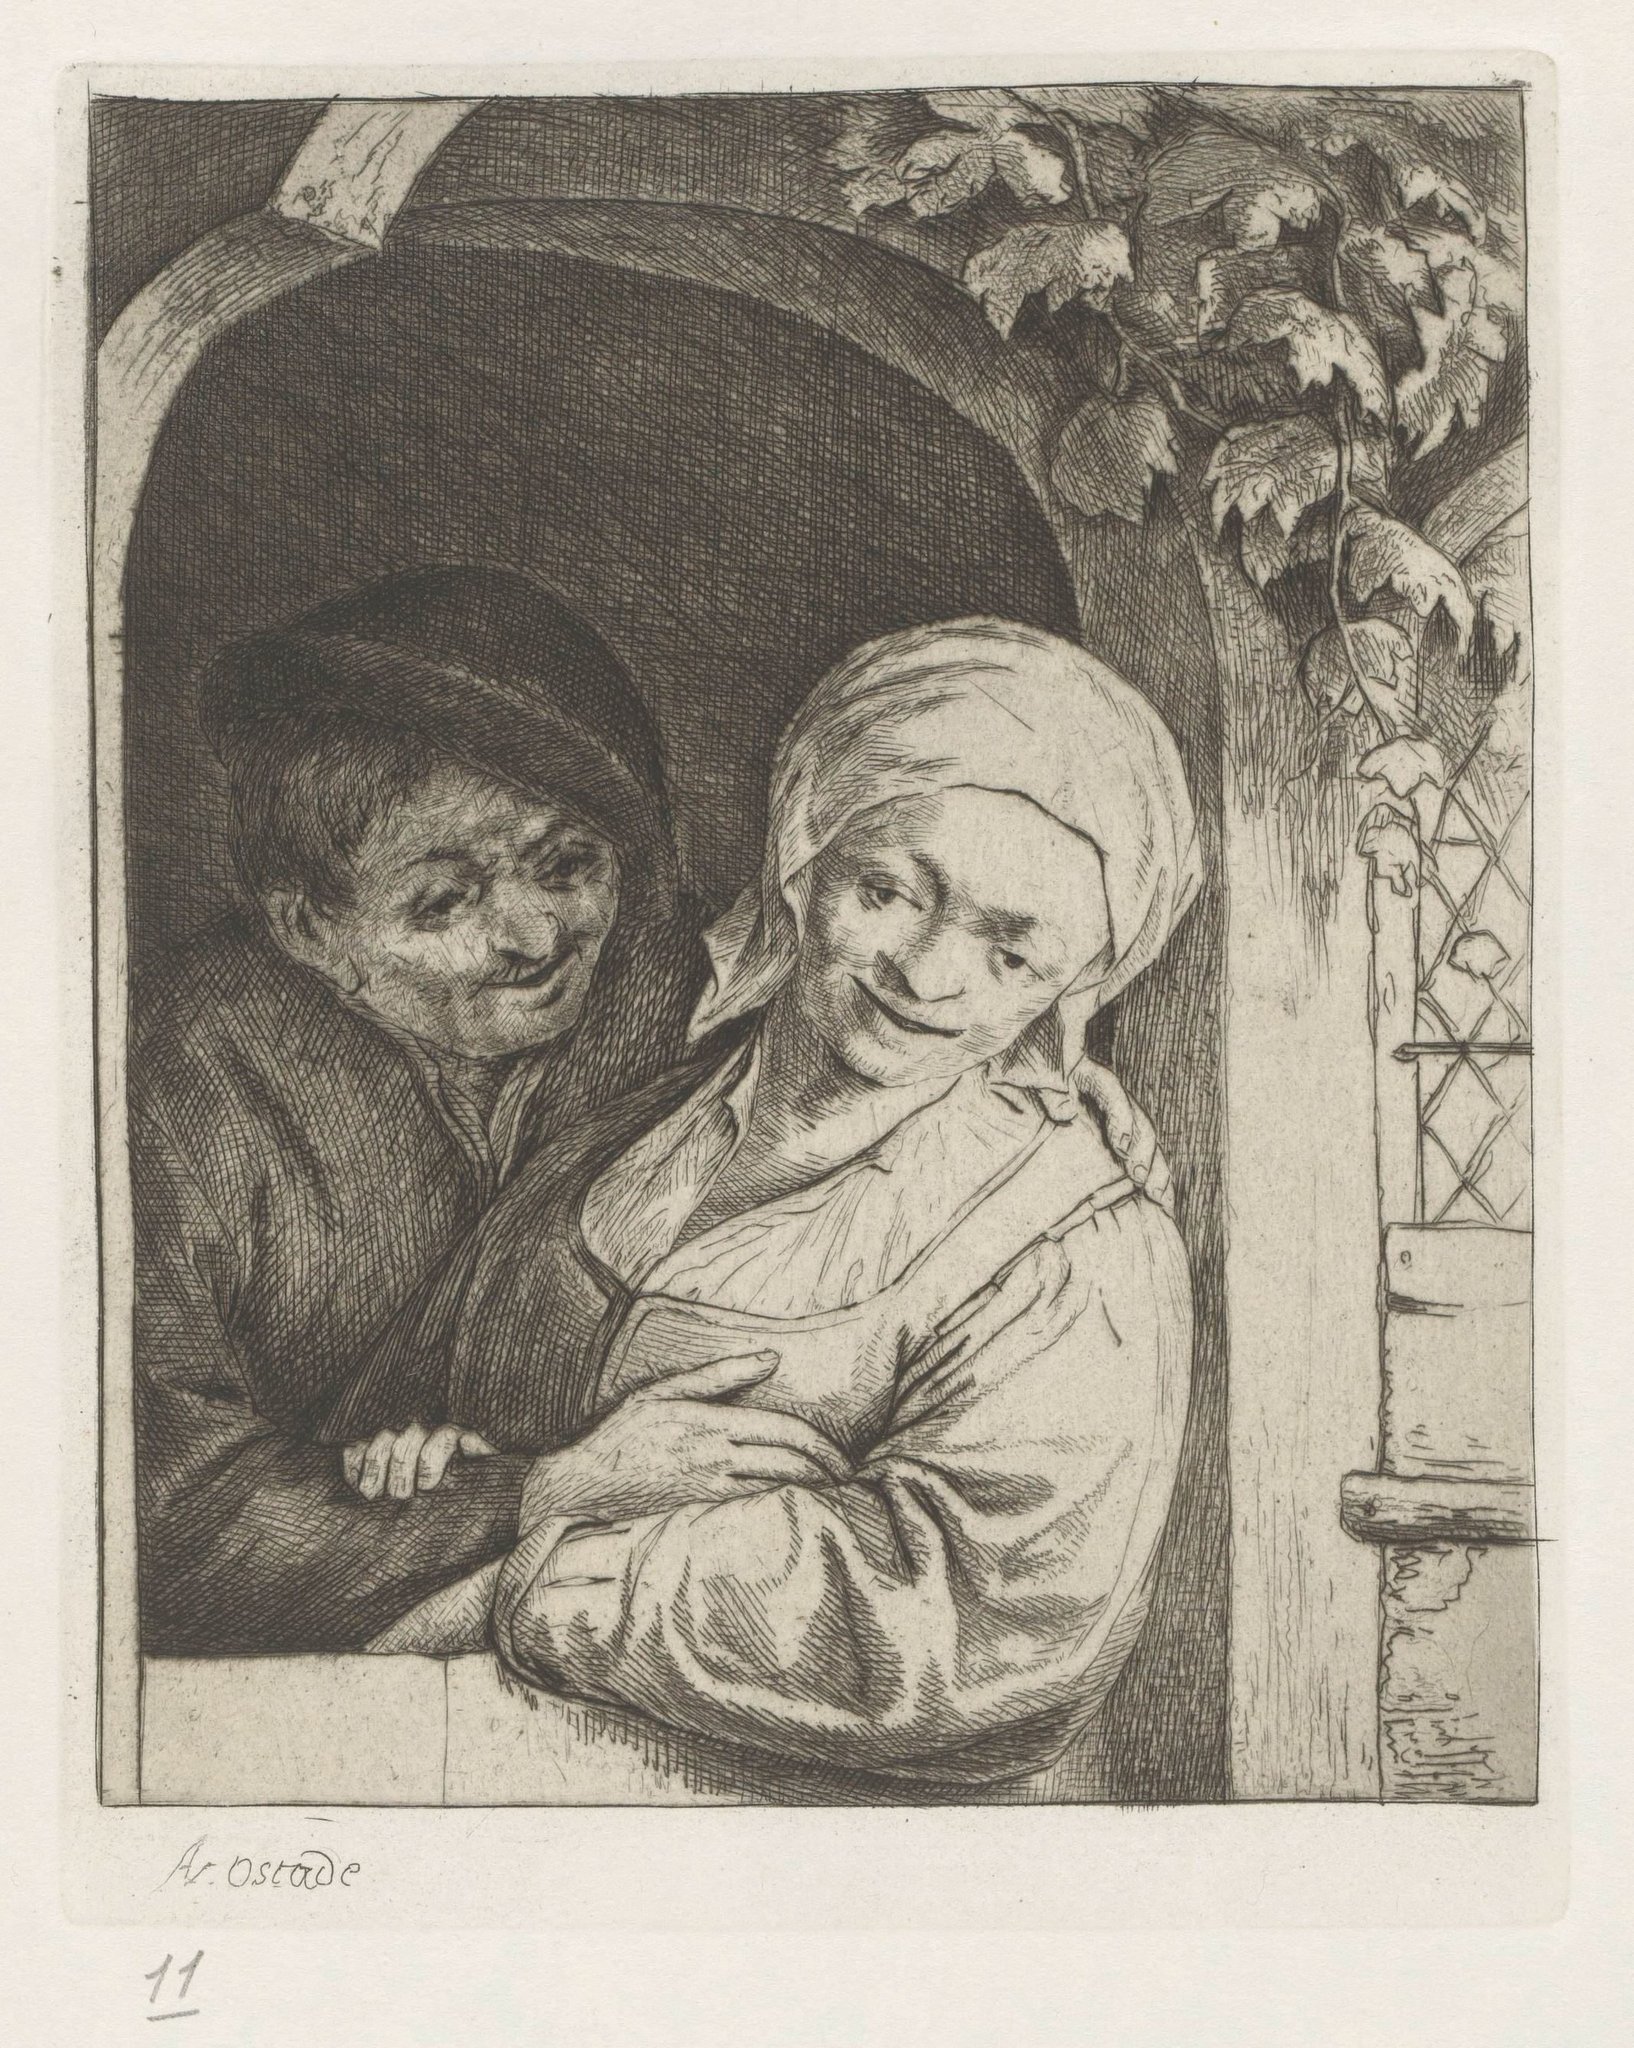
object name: album leaf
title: Boer en boerin als liefdespaar in deuropening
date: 1650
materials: paper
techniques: etching, galvanization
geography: haarlem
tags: couple of lovers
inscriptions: collector's mark: ‘RIJKS / MUSM’, collector's mark: ‘B’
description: De prent maakt deel uit van een portefeuille.